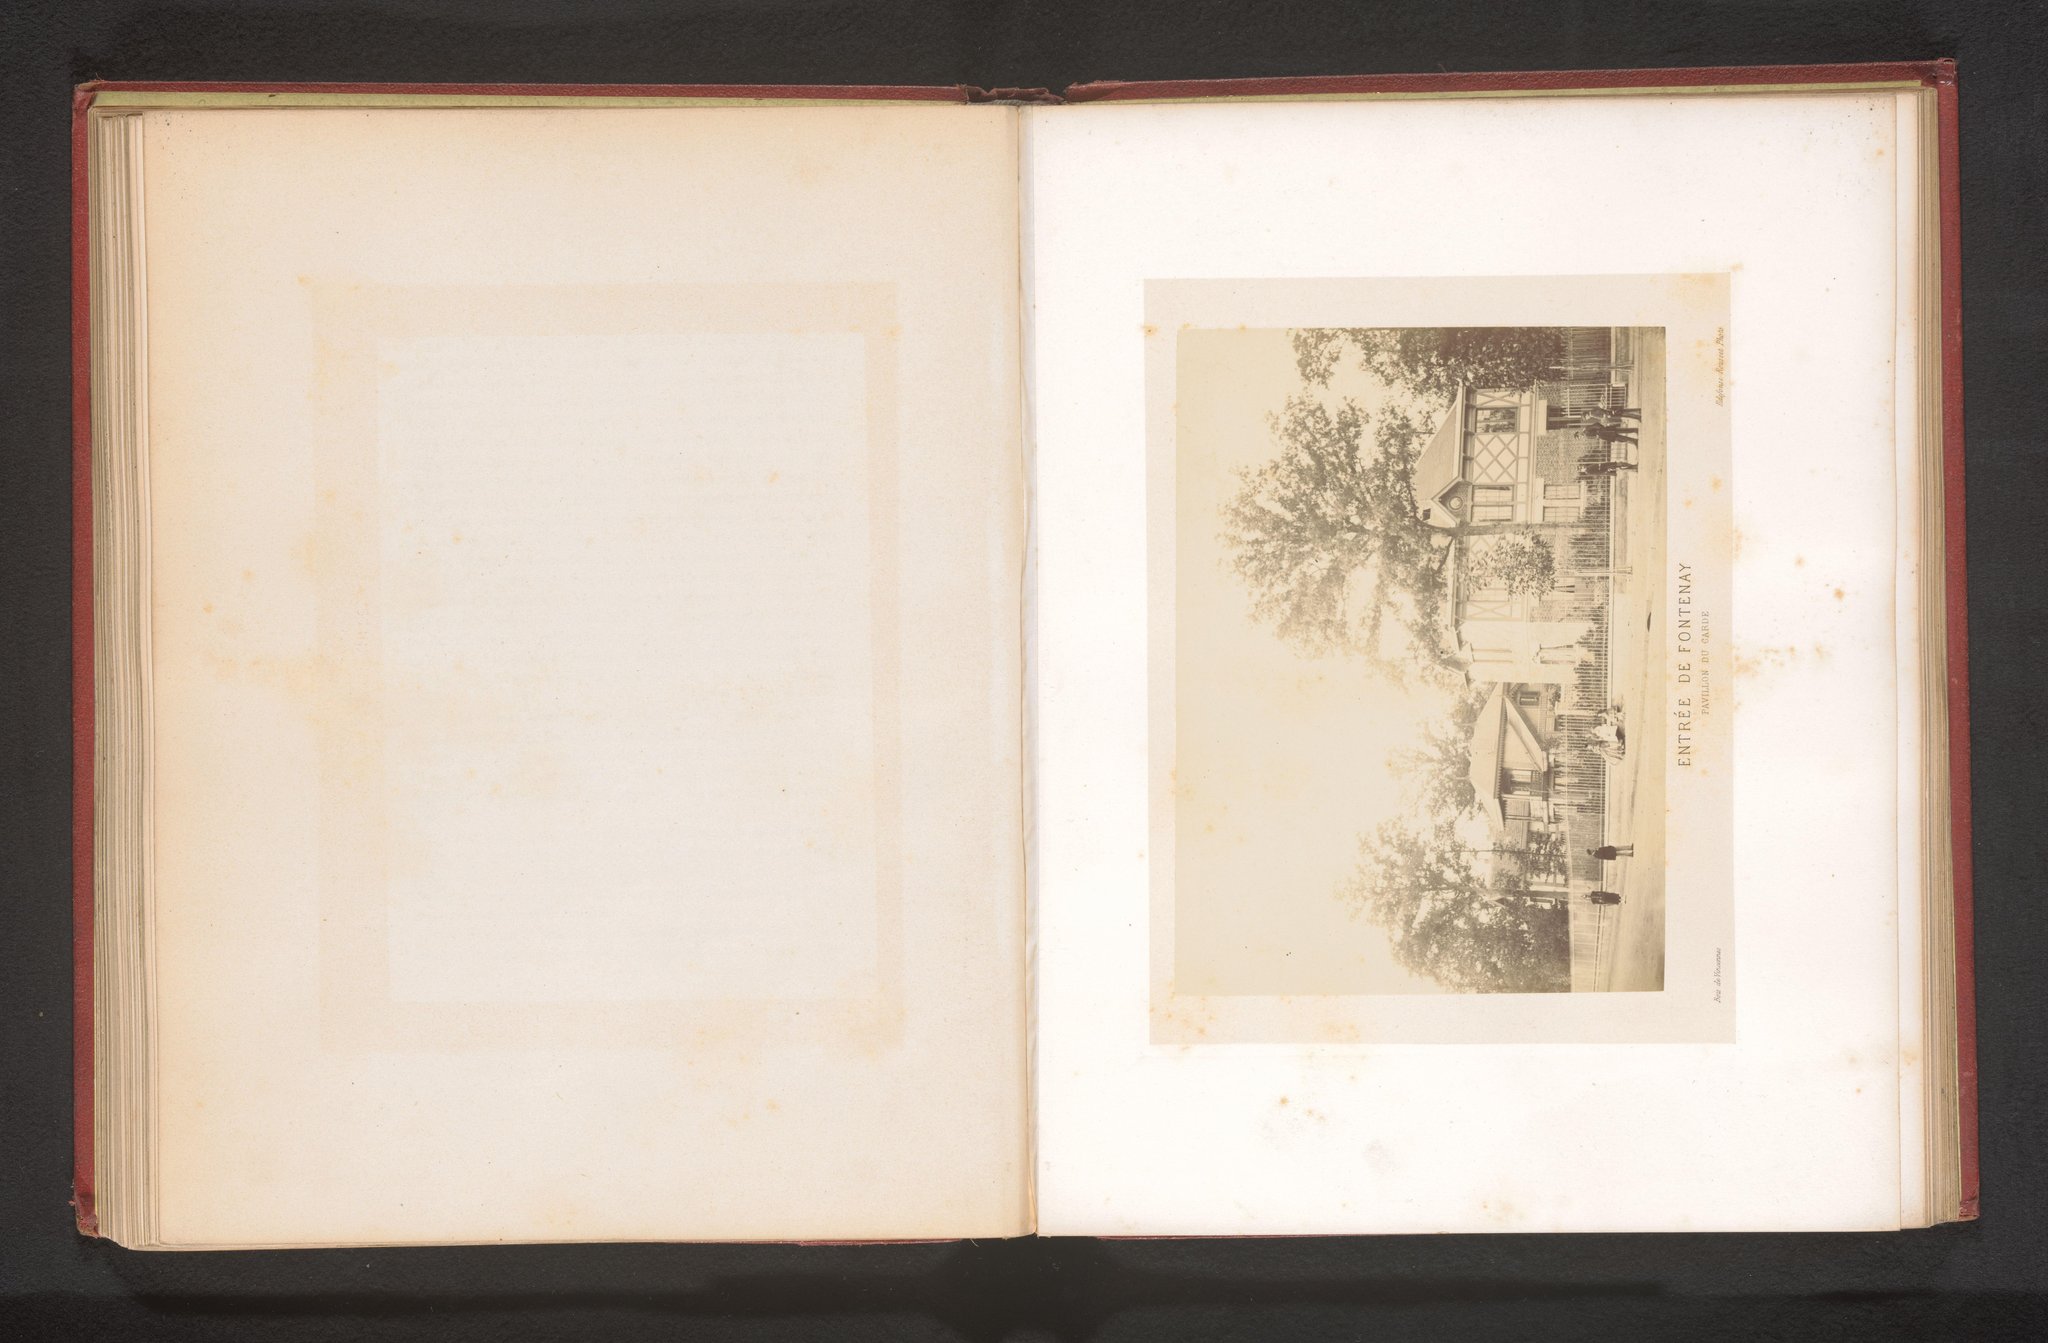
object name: photograph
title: Entrée de Fontenay pavillon du garde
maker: ildefonse rousset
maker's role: fotograaf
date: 1861-1866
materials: photographic support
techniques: albumen print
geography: paris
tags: housing, façade (of house or building)